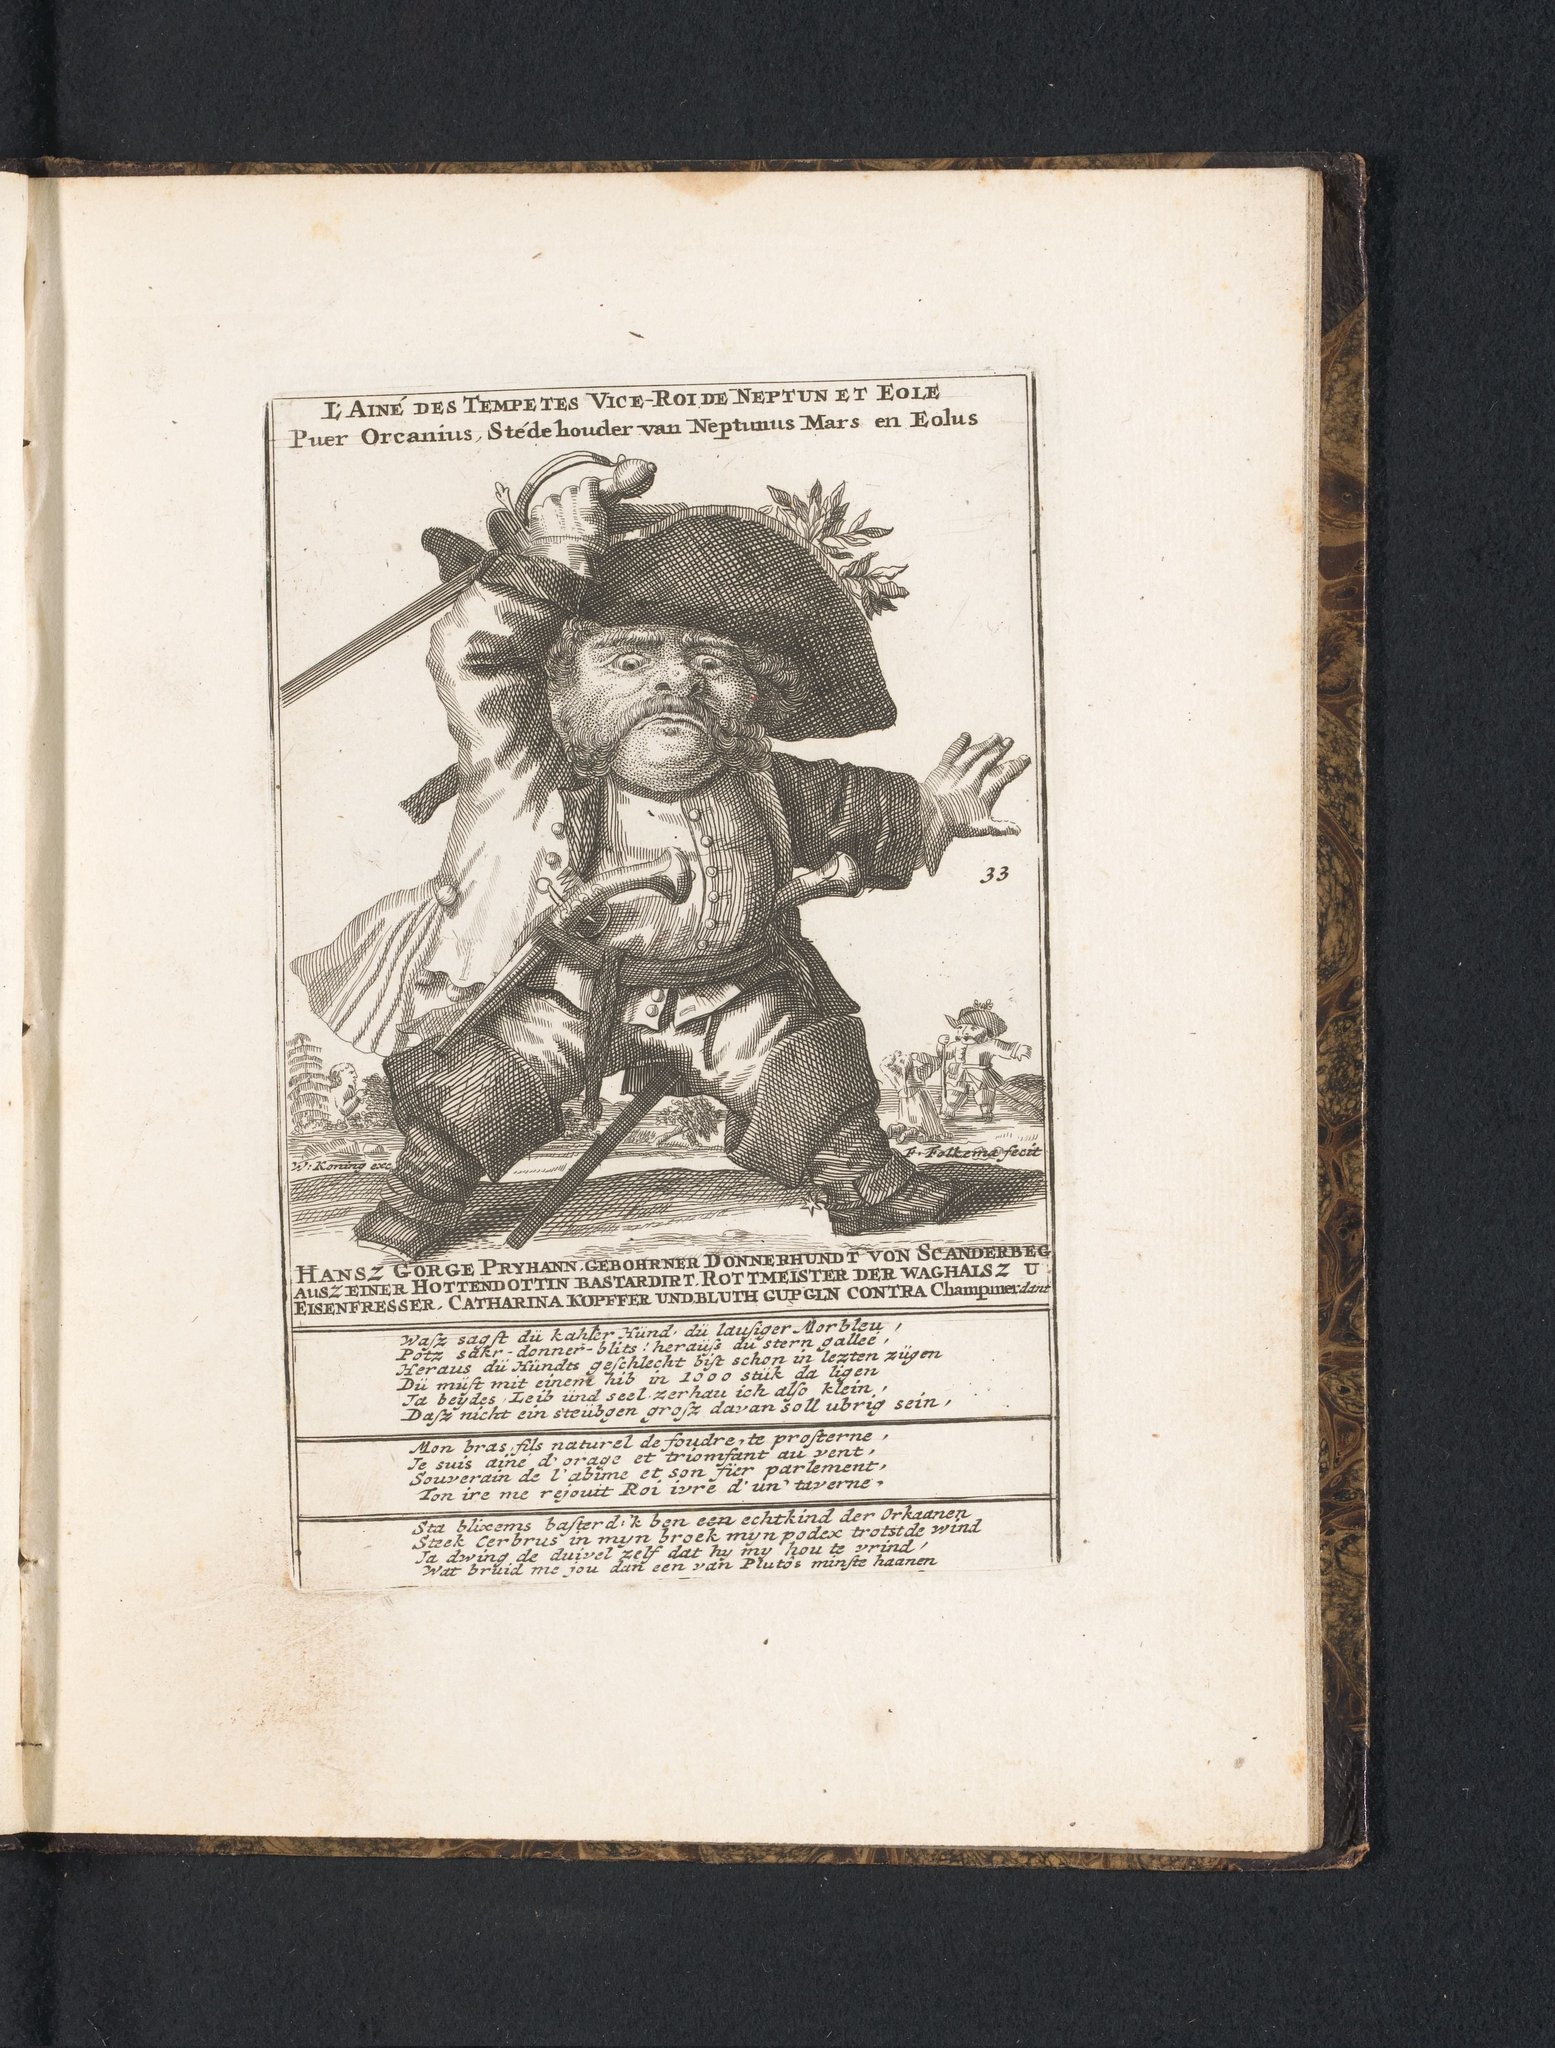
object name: print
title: Bombario Actionist en de Geest van Esopus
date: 1718-1720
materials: paper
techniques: etching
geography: amsterdam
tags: caricatures (human types), little people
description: De kleine mens Puer Orcanius als woeste officier met opgeheven zwaard. In het onderschrift verzen in het Duits, Frans en Nederlands. Genummerd rechts midden: 33. Onderdeel van deel II in de tweede Nederlandse gebonden uitgave uit 1720 (en gerelateerd aan de Windhandel in dat jaar) van een serie karikaturen van kleine mensen, bekend als Het Dwergentooneel.